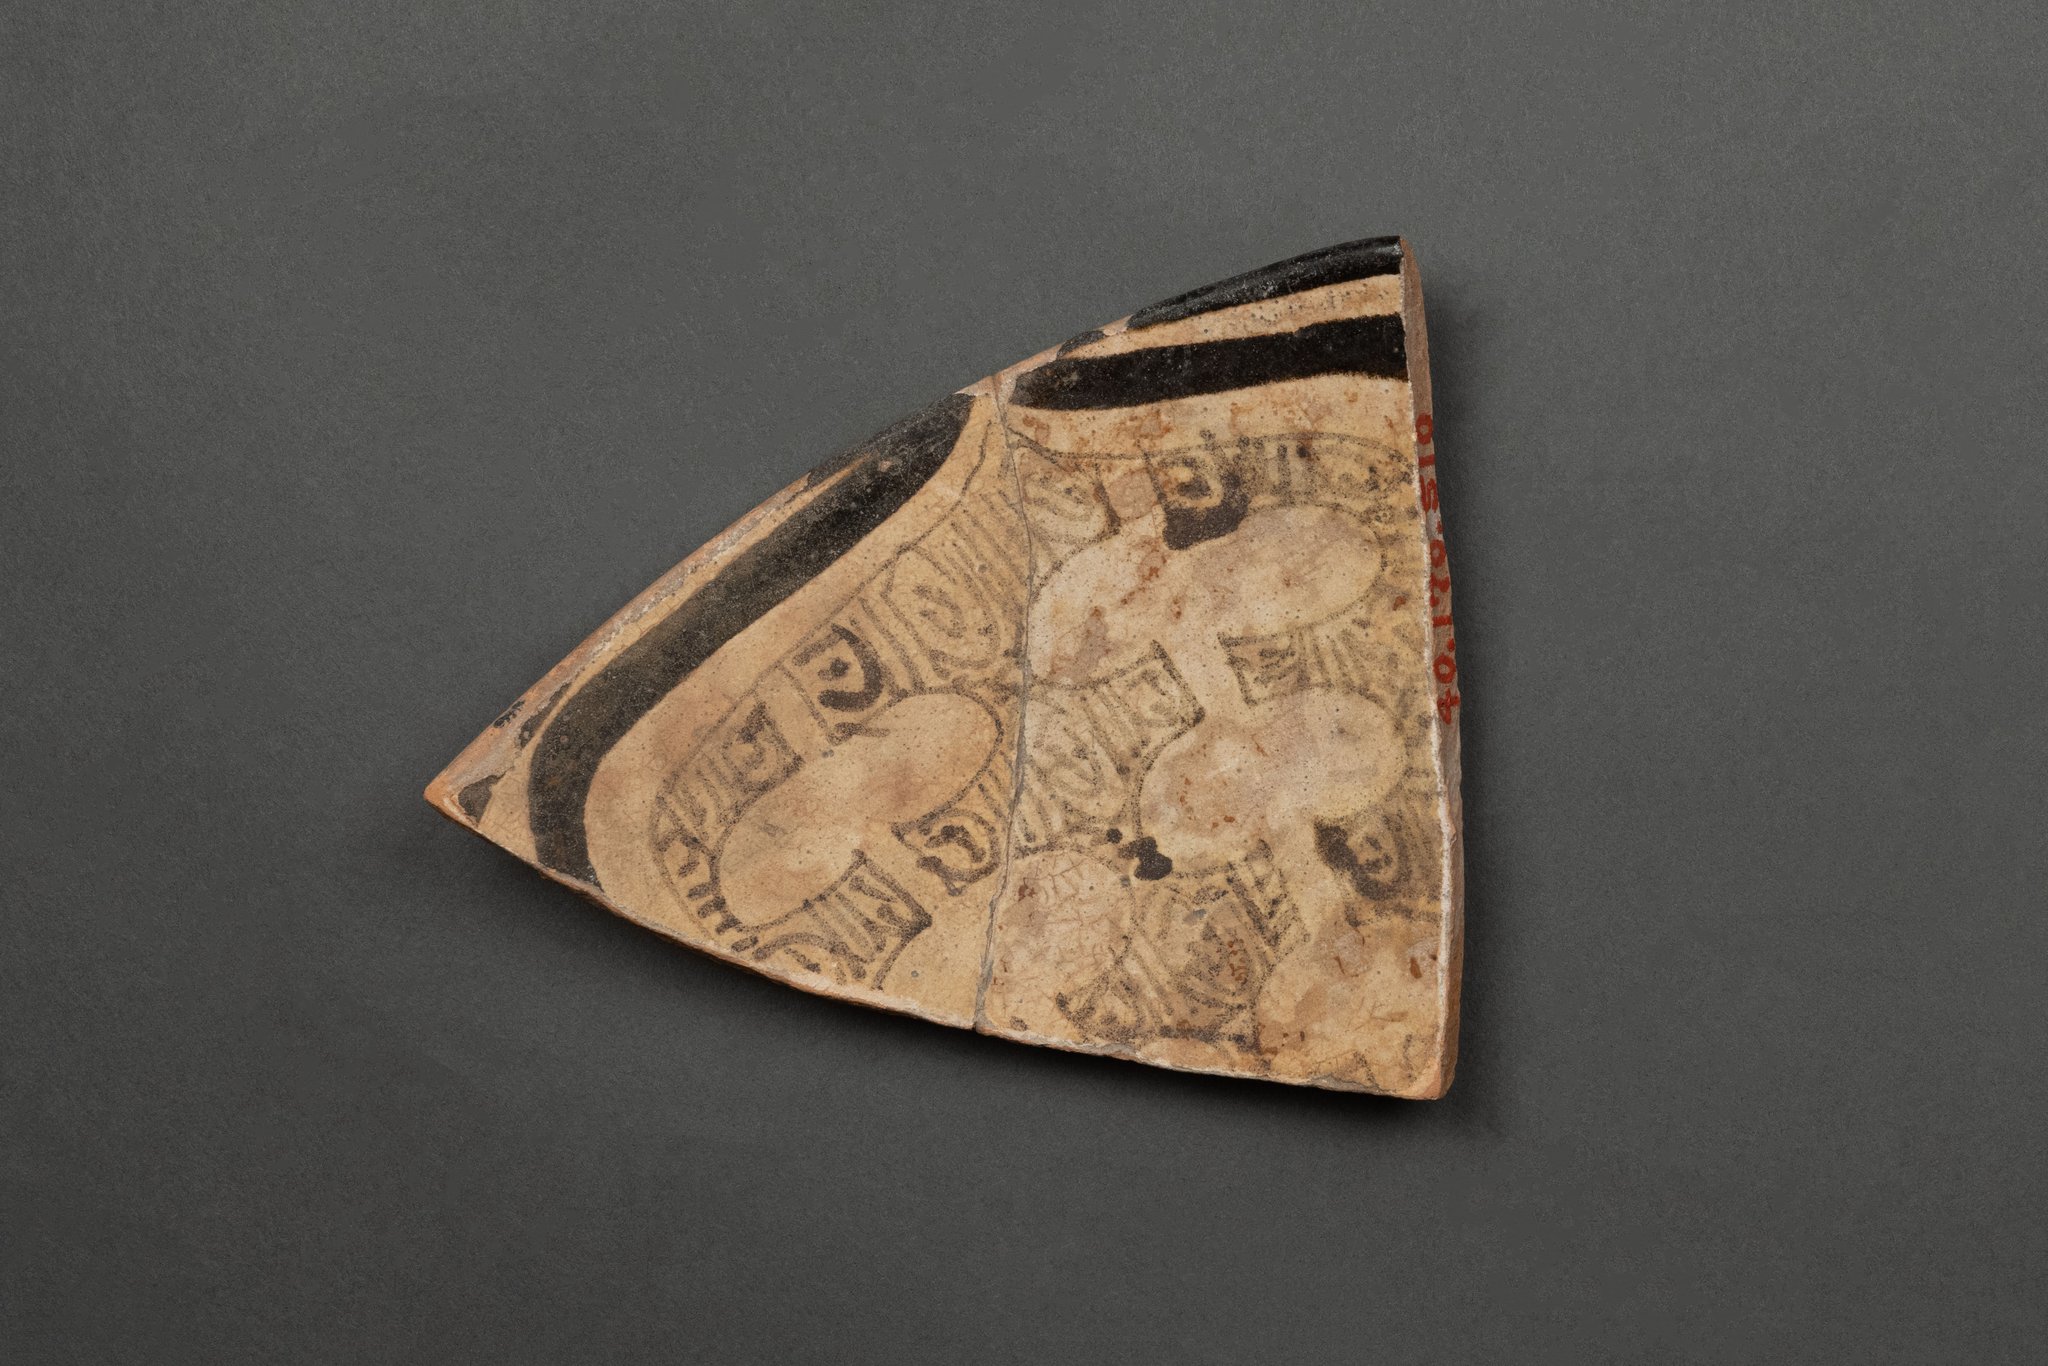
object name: fragment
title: Ceramic Fragment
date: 801-1000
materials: earthenware, glaze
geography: iran